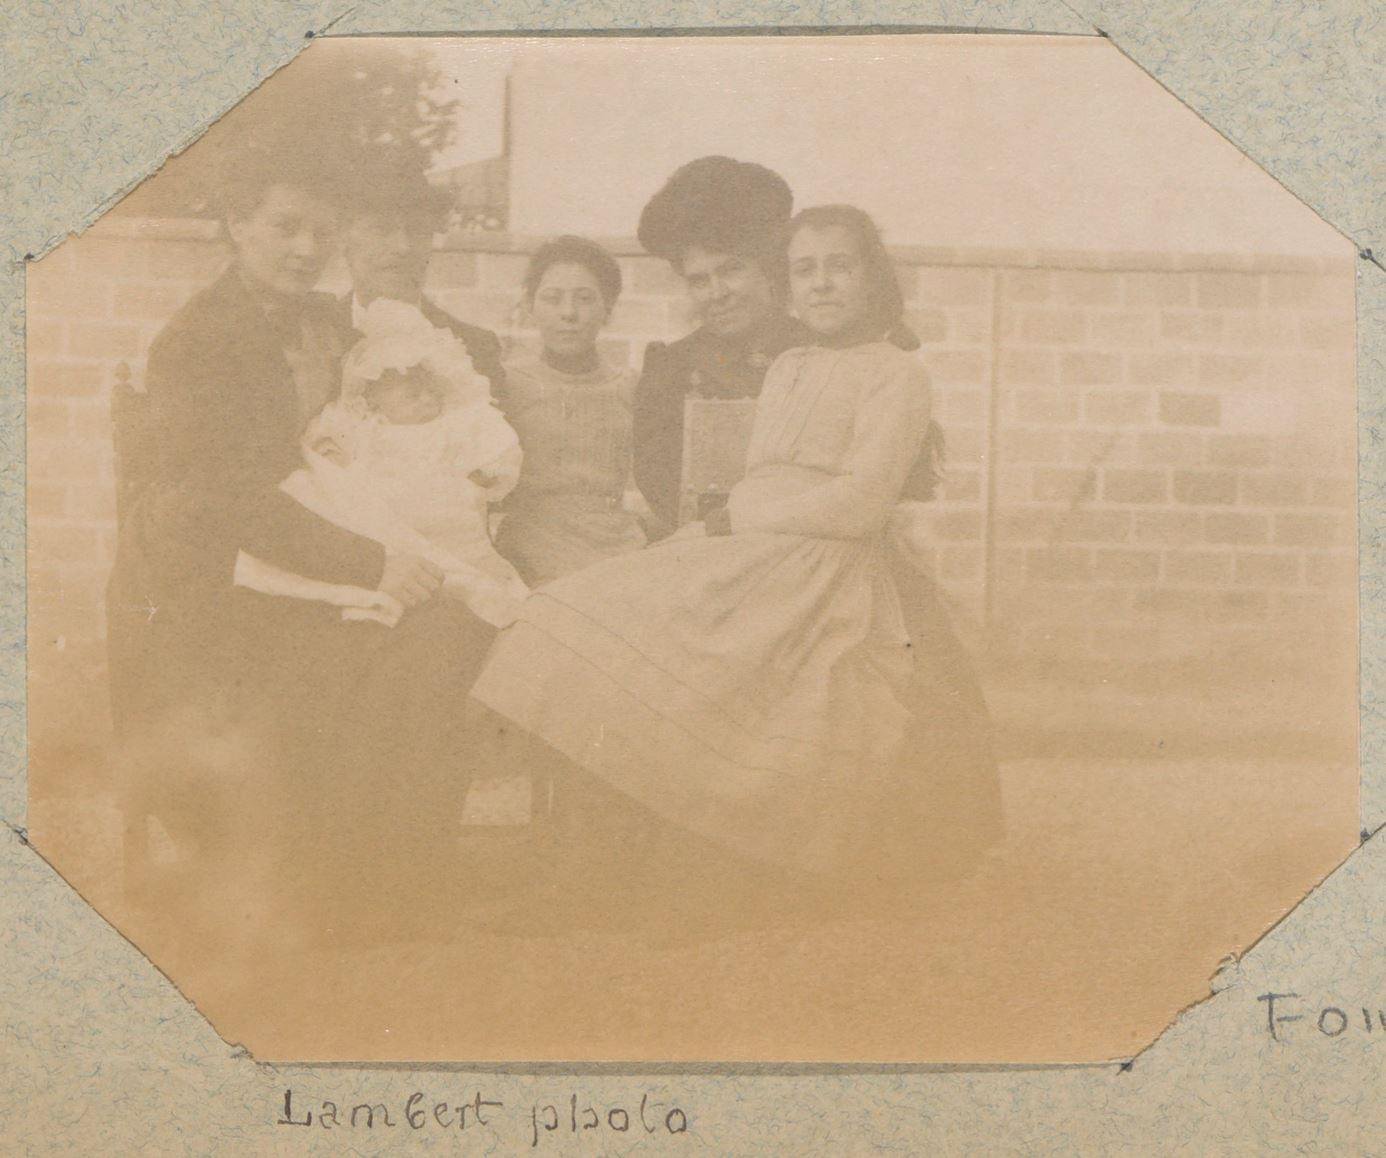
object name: album leaf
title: Groepsportret van drie volwassenen en drie kinderen, vermoedelijk in Frankrijk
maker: lambert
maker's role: painter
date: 1890-1900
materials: paper, photographic support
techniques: albumen print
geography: france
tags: family group, especially parents with their child(ren), france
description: Onderdeel van Album van een Franse amateur met foto's van Frankrijk, Algerije, Palmyra, de Wereldtentoonstelling van 1900 en van bekende Fransen.